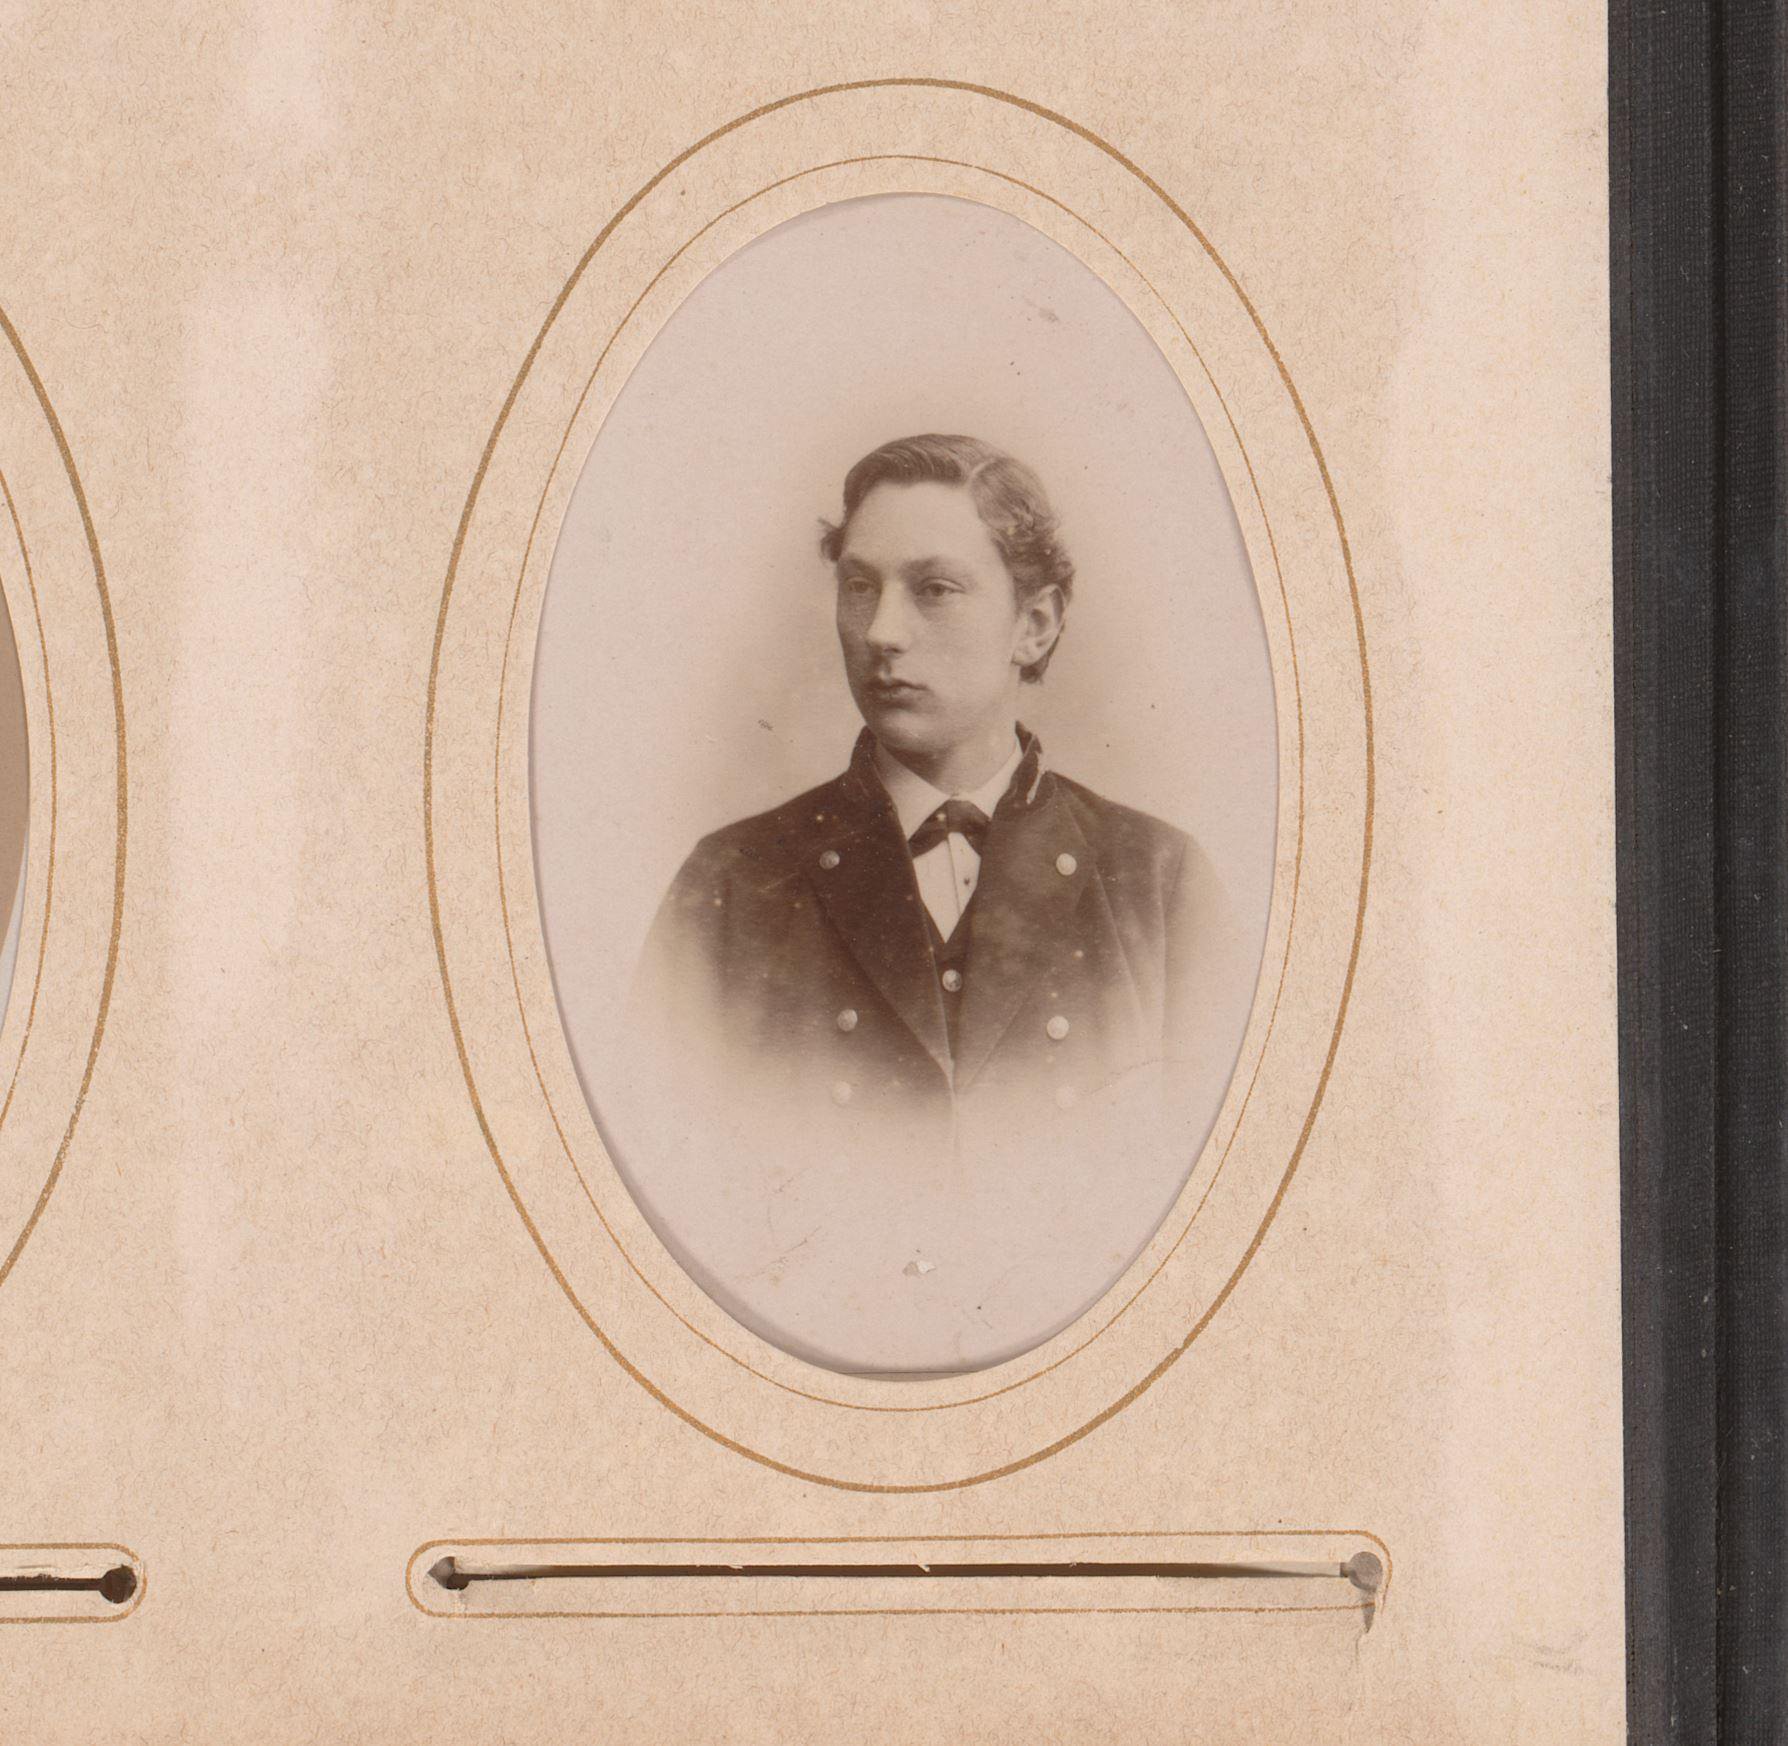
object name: carte de visite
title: Portret van een jongeman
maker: albert greiner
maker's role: fotograaf, fotostudio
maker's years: 1833-1890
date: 1861-1889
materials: cardboard, photographic support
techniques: albumen print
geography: amsterdam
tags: historical persons, youth, adolescent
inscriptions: inscription: ‘Greiner's Studio/ Amsterdam’